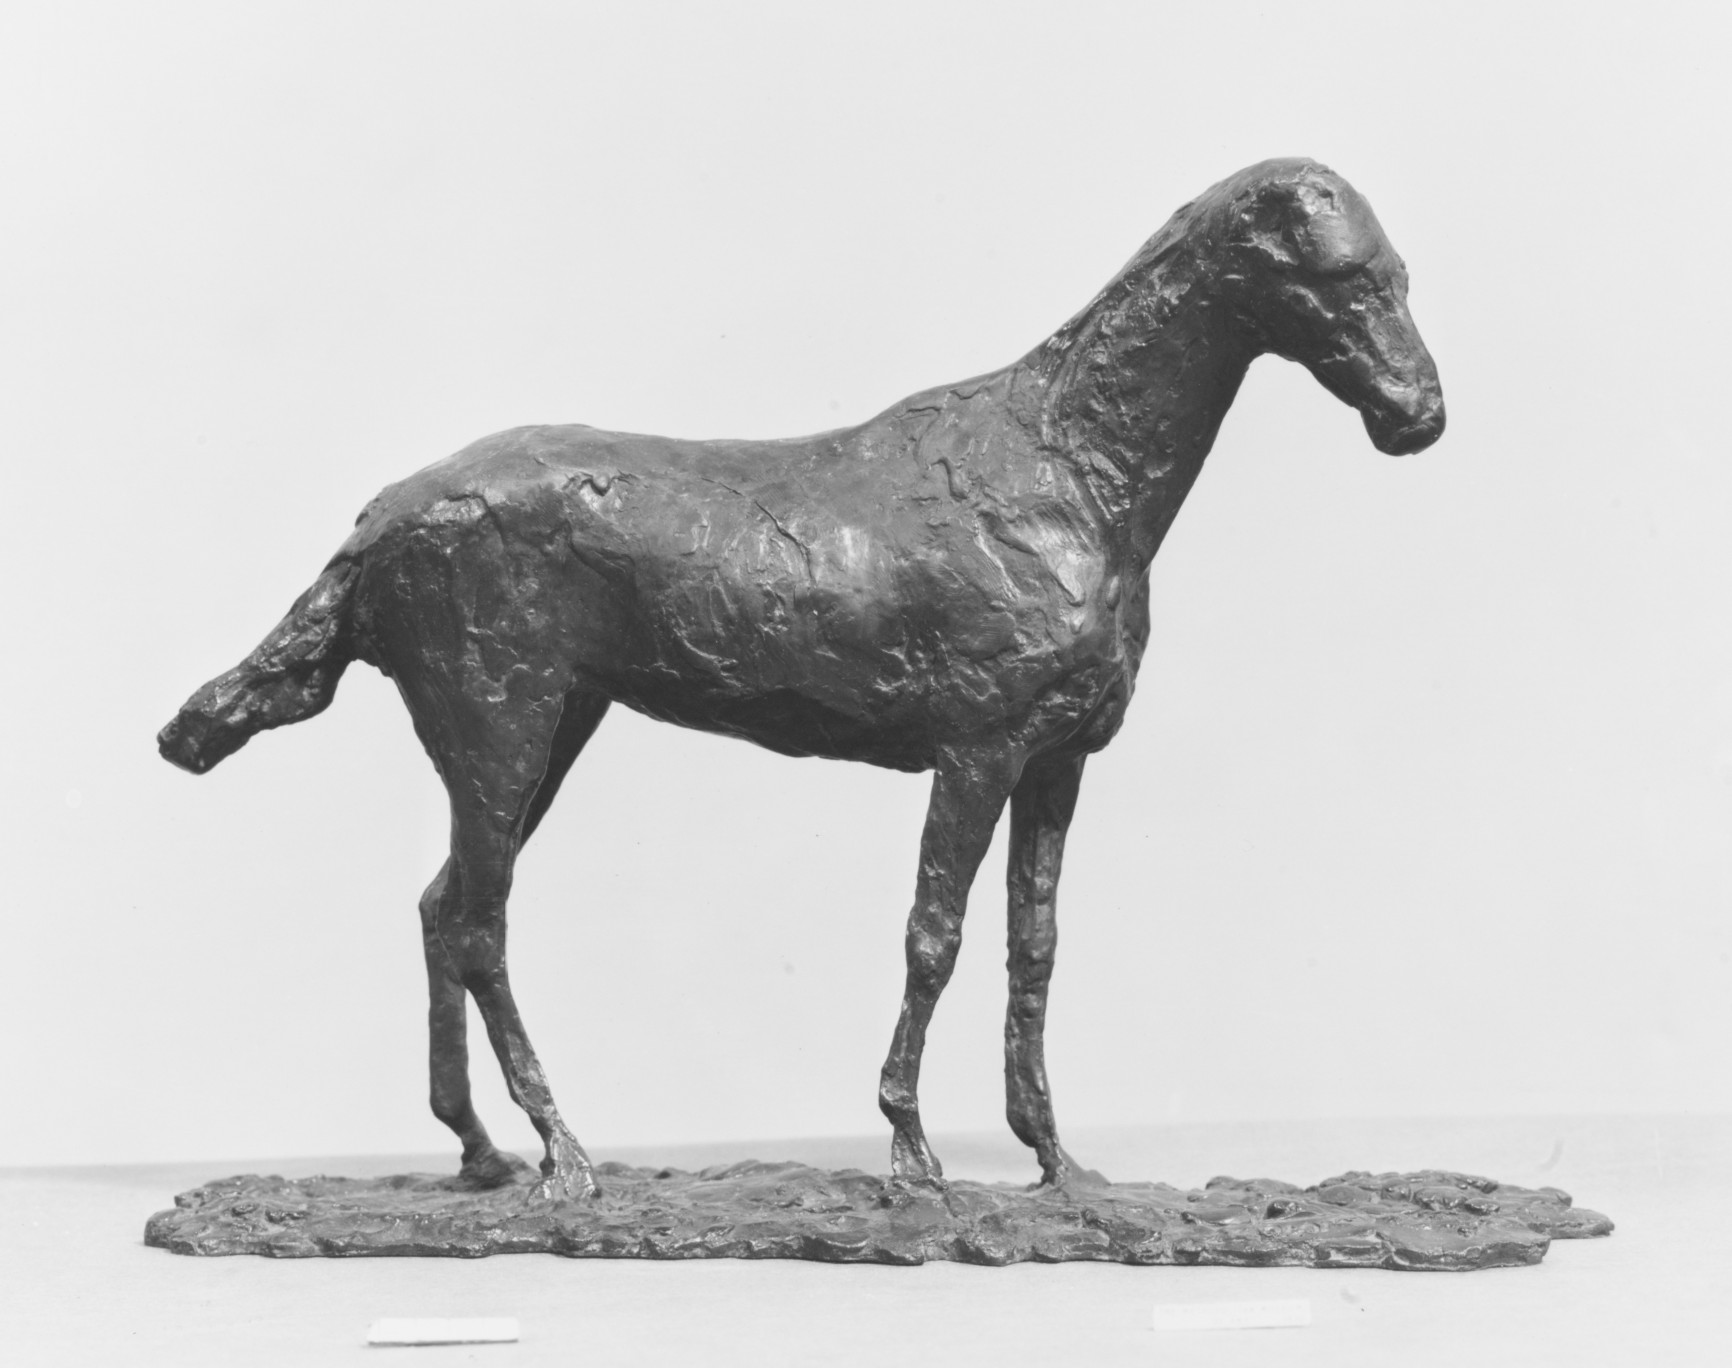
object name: statuette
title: Study of a Mustang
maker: edgar degas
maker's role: artist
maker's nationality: french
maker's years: 1834-1917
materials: bronze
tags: horses